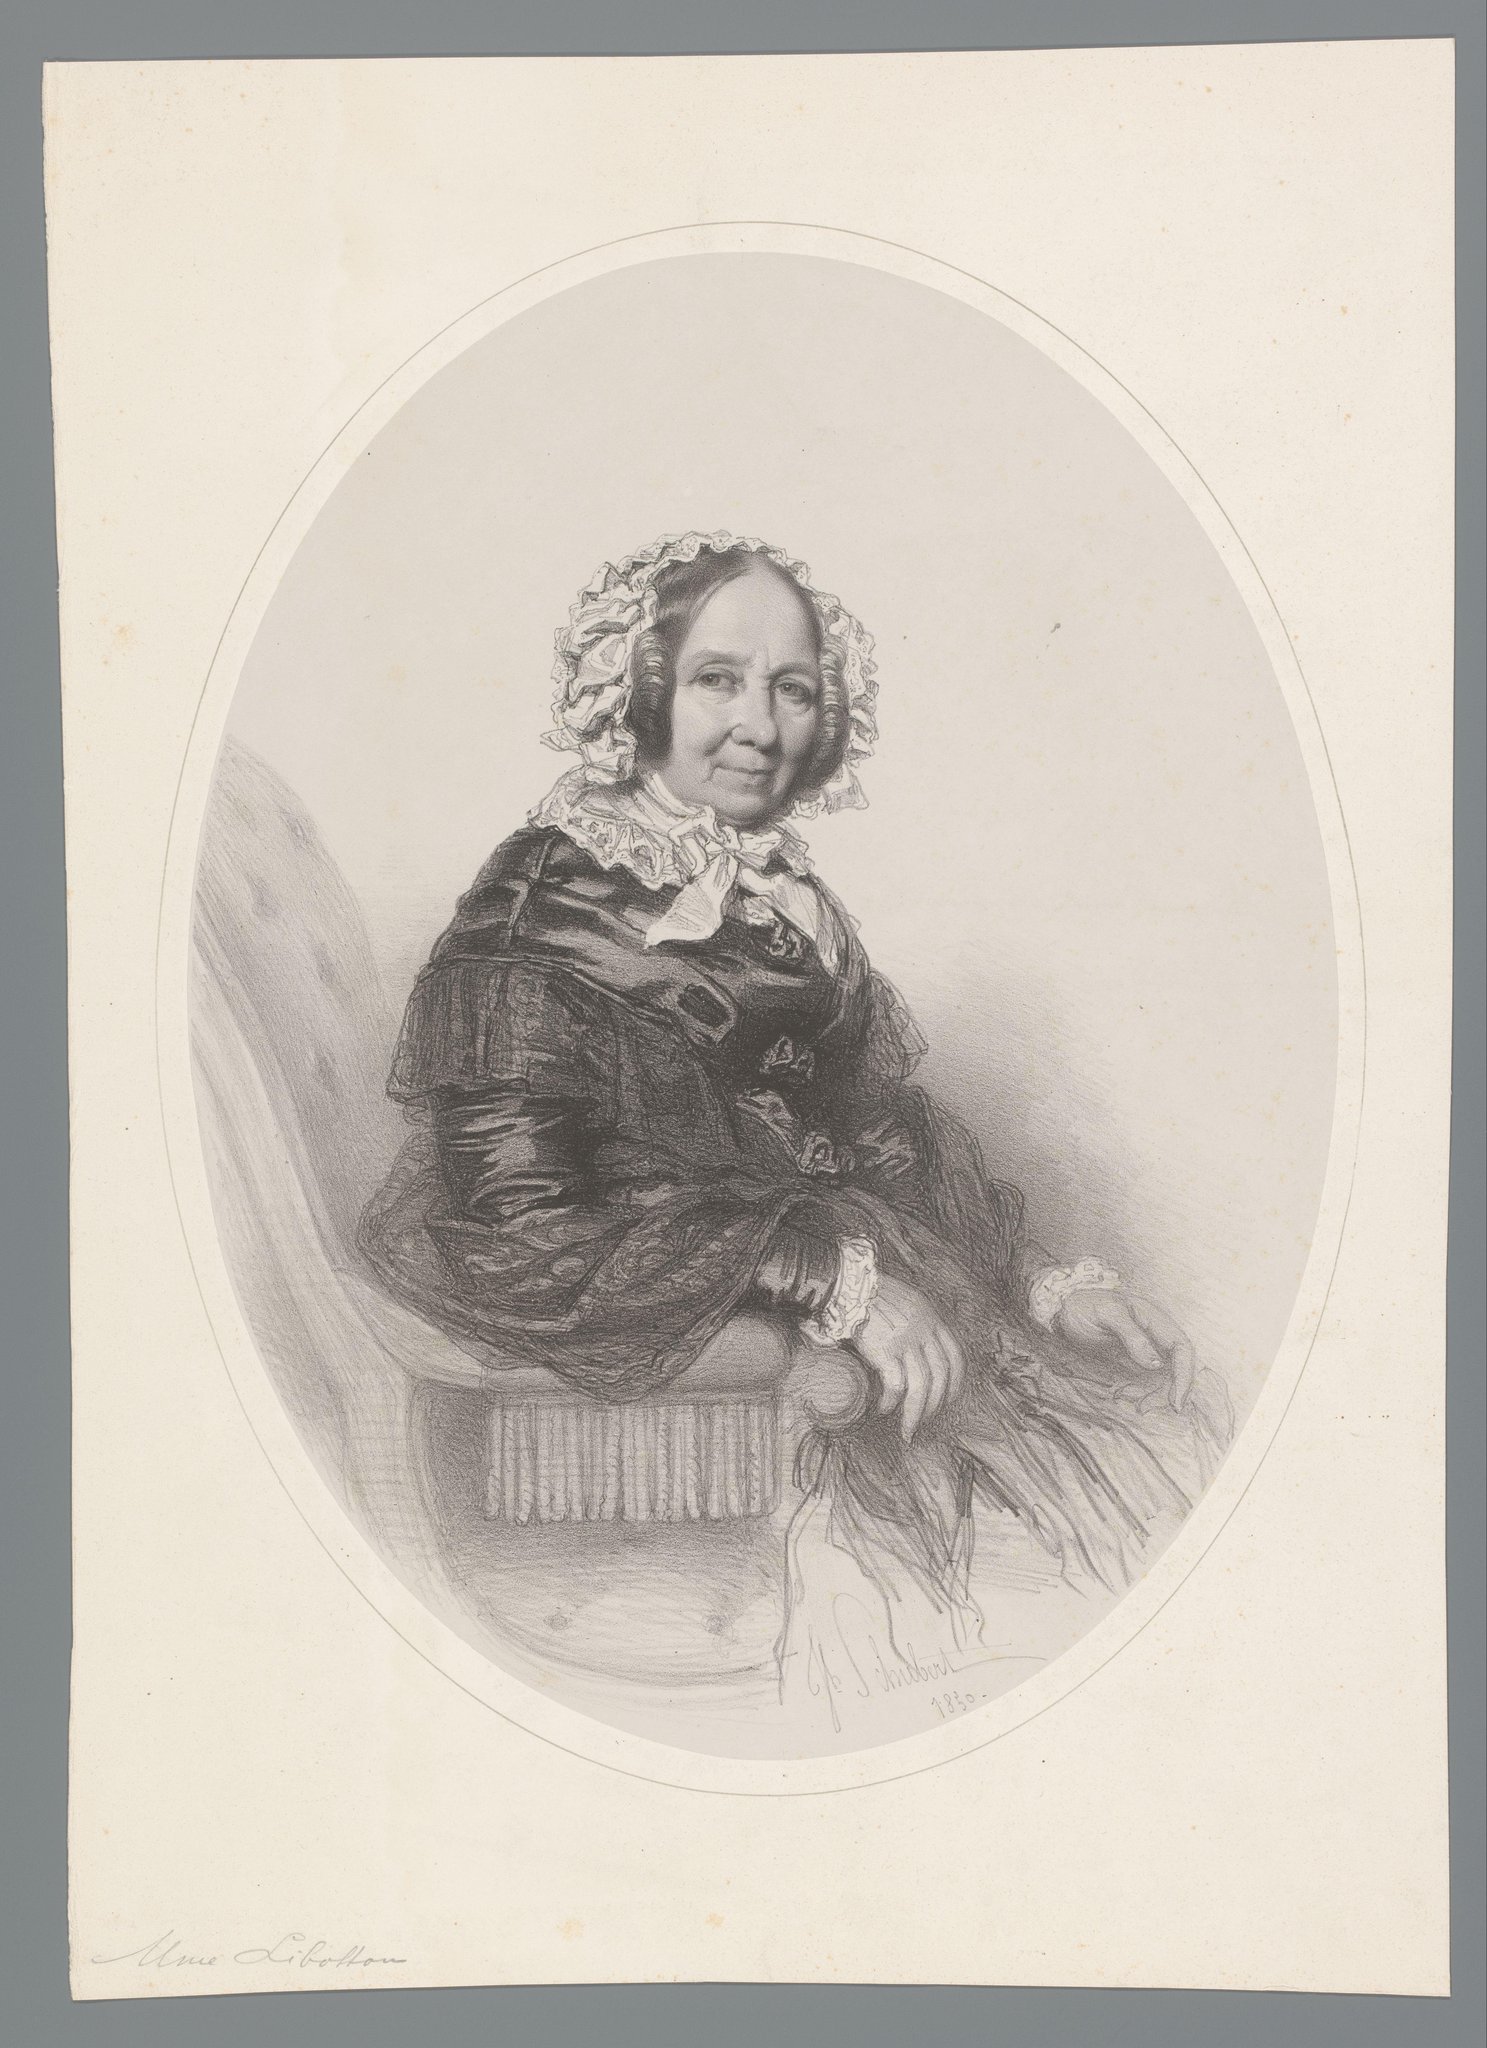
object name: print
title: Portret van mevrouw Libotton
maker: joseph schubert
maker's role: print maker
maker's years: 1816-1885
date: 1850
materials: paper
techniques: lithograph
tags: historical persons - bb - woman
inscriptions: collector's mark: Lugt 2228